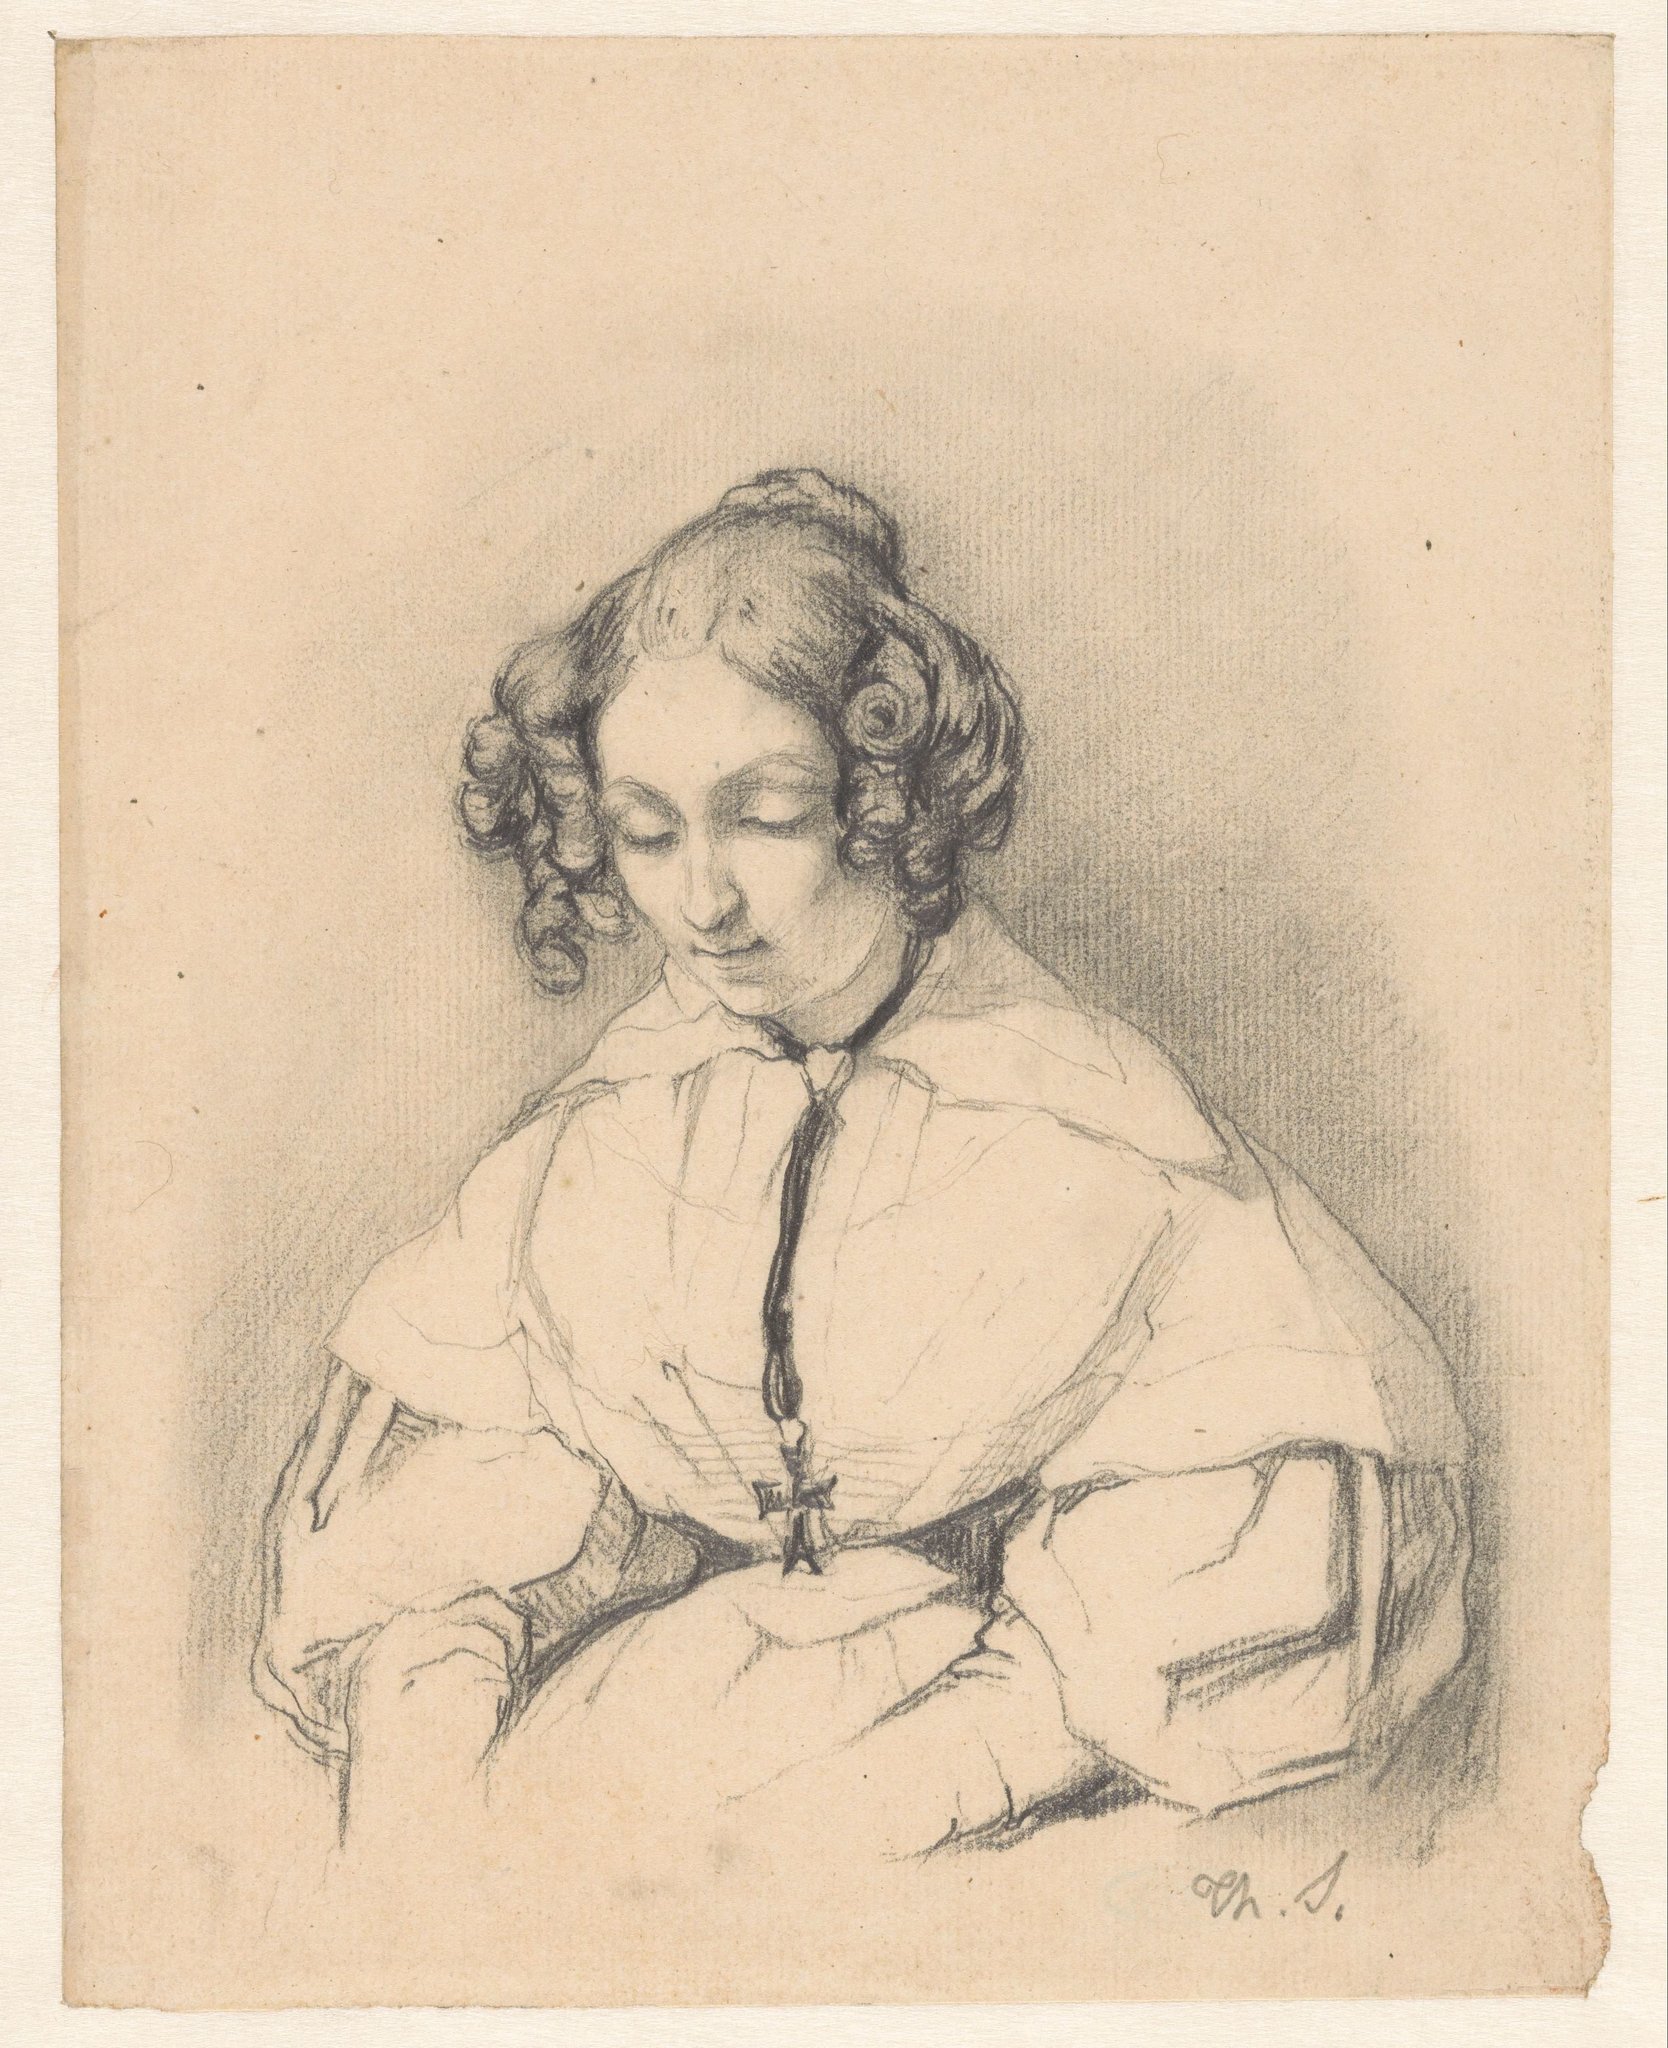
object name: drawing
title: Portret van een zittende vrouw met de ogen neergeslagen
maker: theodoor schaepkens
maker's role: draughtsman, print maker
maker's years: 1810-1883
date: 1820-1883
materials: paper, pencil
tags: anonymous historical person portrayed alone